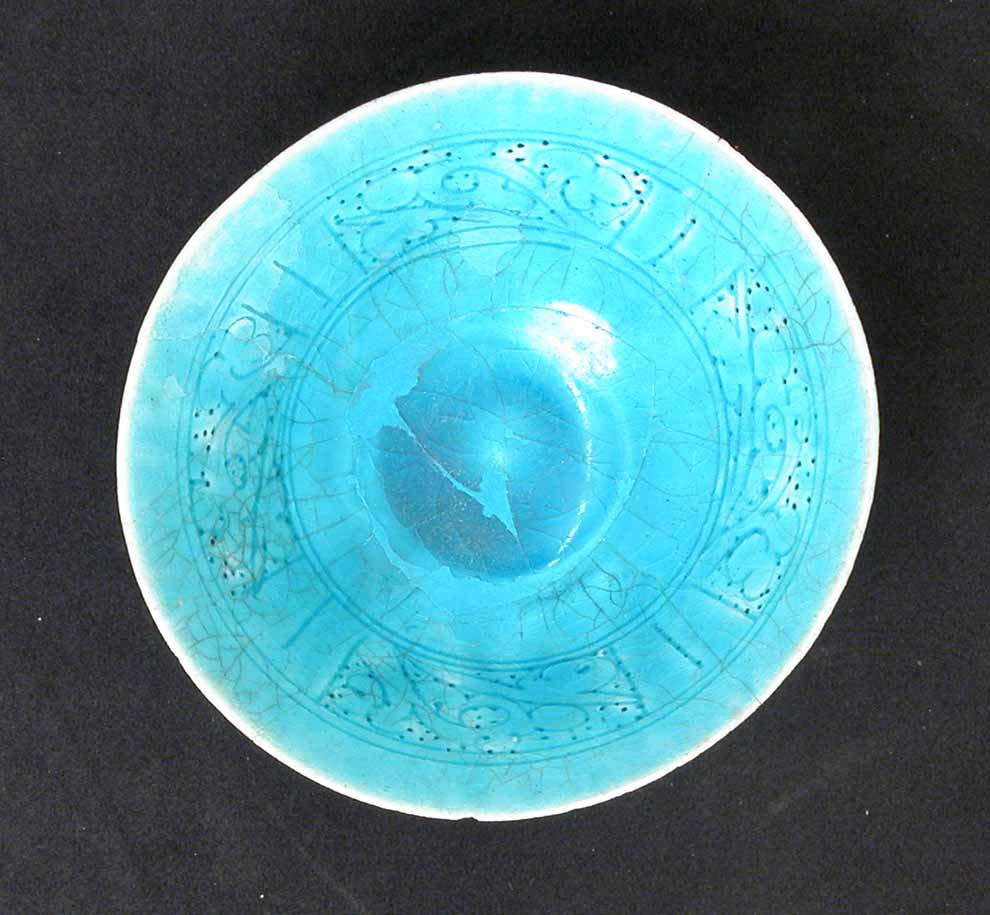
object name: bowl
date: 1101-1300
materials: stonepaste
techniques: glazing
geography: iran